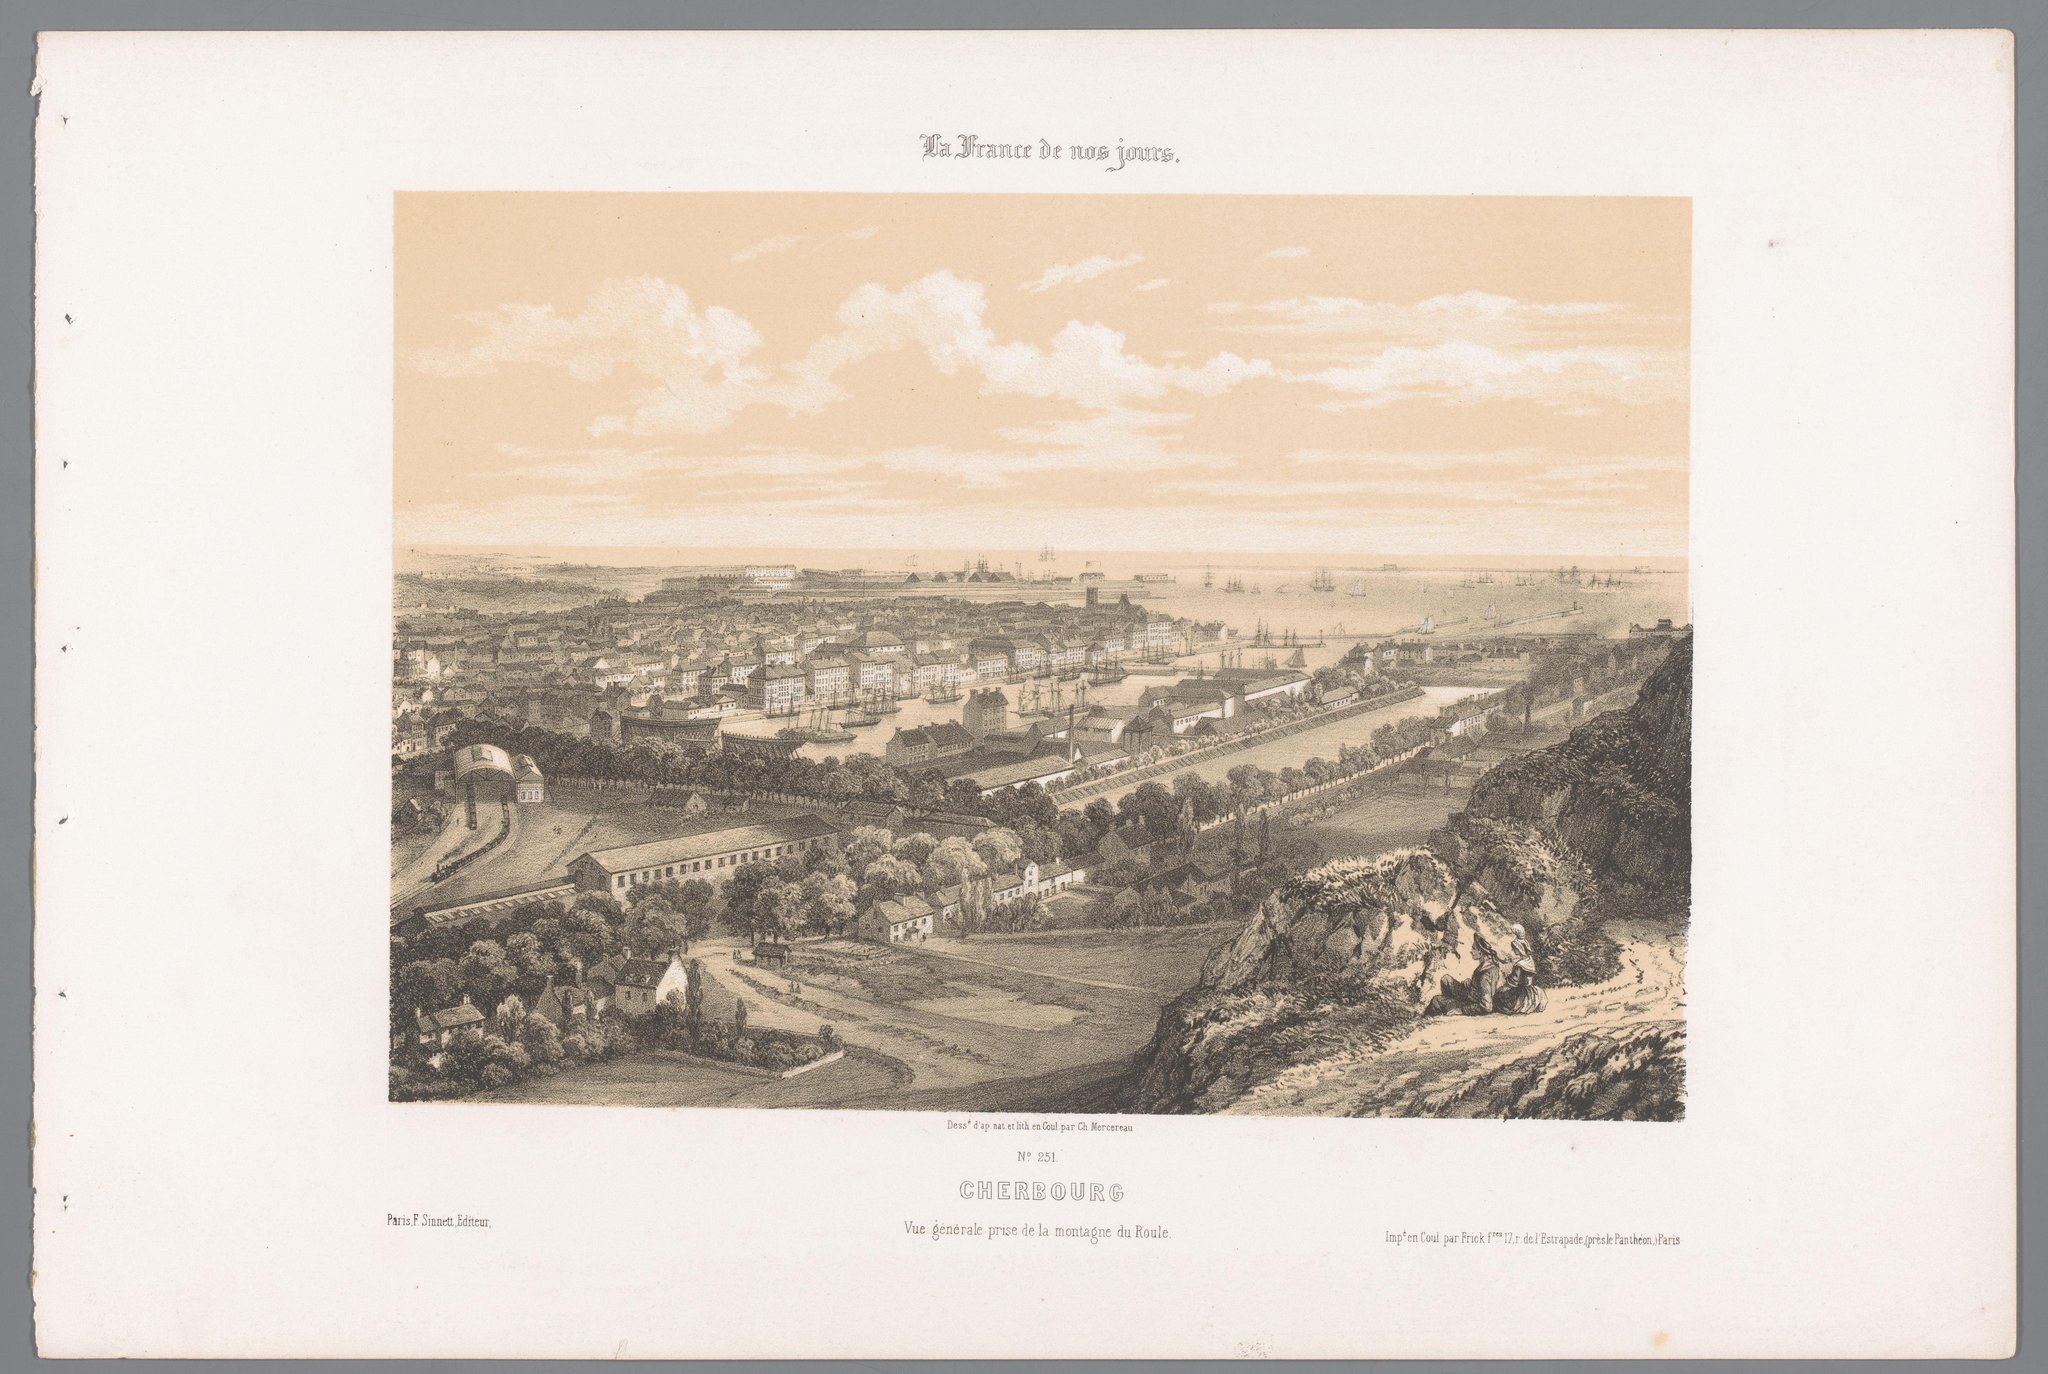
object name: print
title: Hedendaags Frankrijk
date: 1856-1874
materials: paper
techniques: tone lithography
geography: paris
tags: city-view, and landscape with man-made constructions, merchant shipping, shipping trade, sea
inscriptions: collector's mark: Lugt 2228